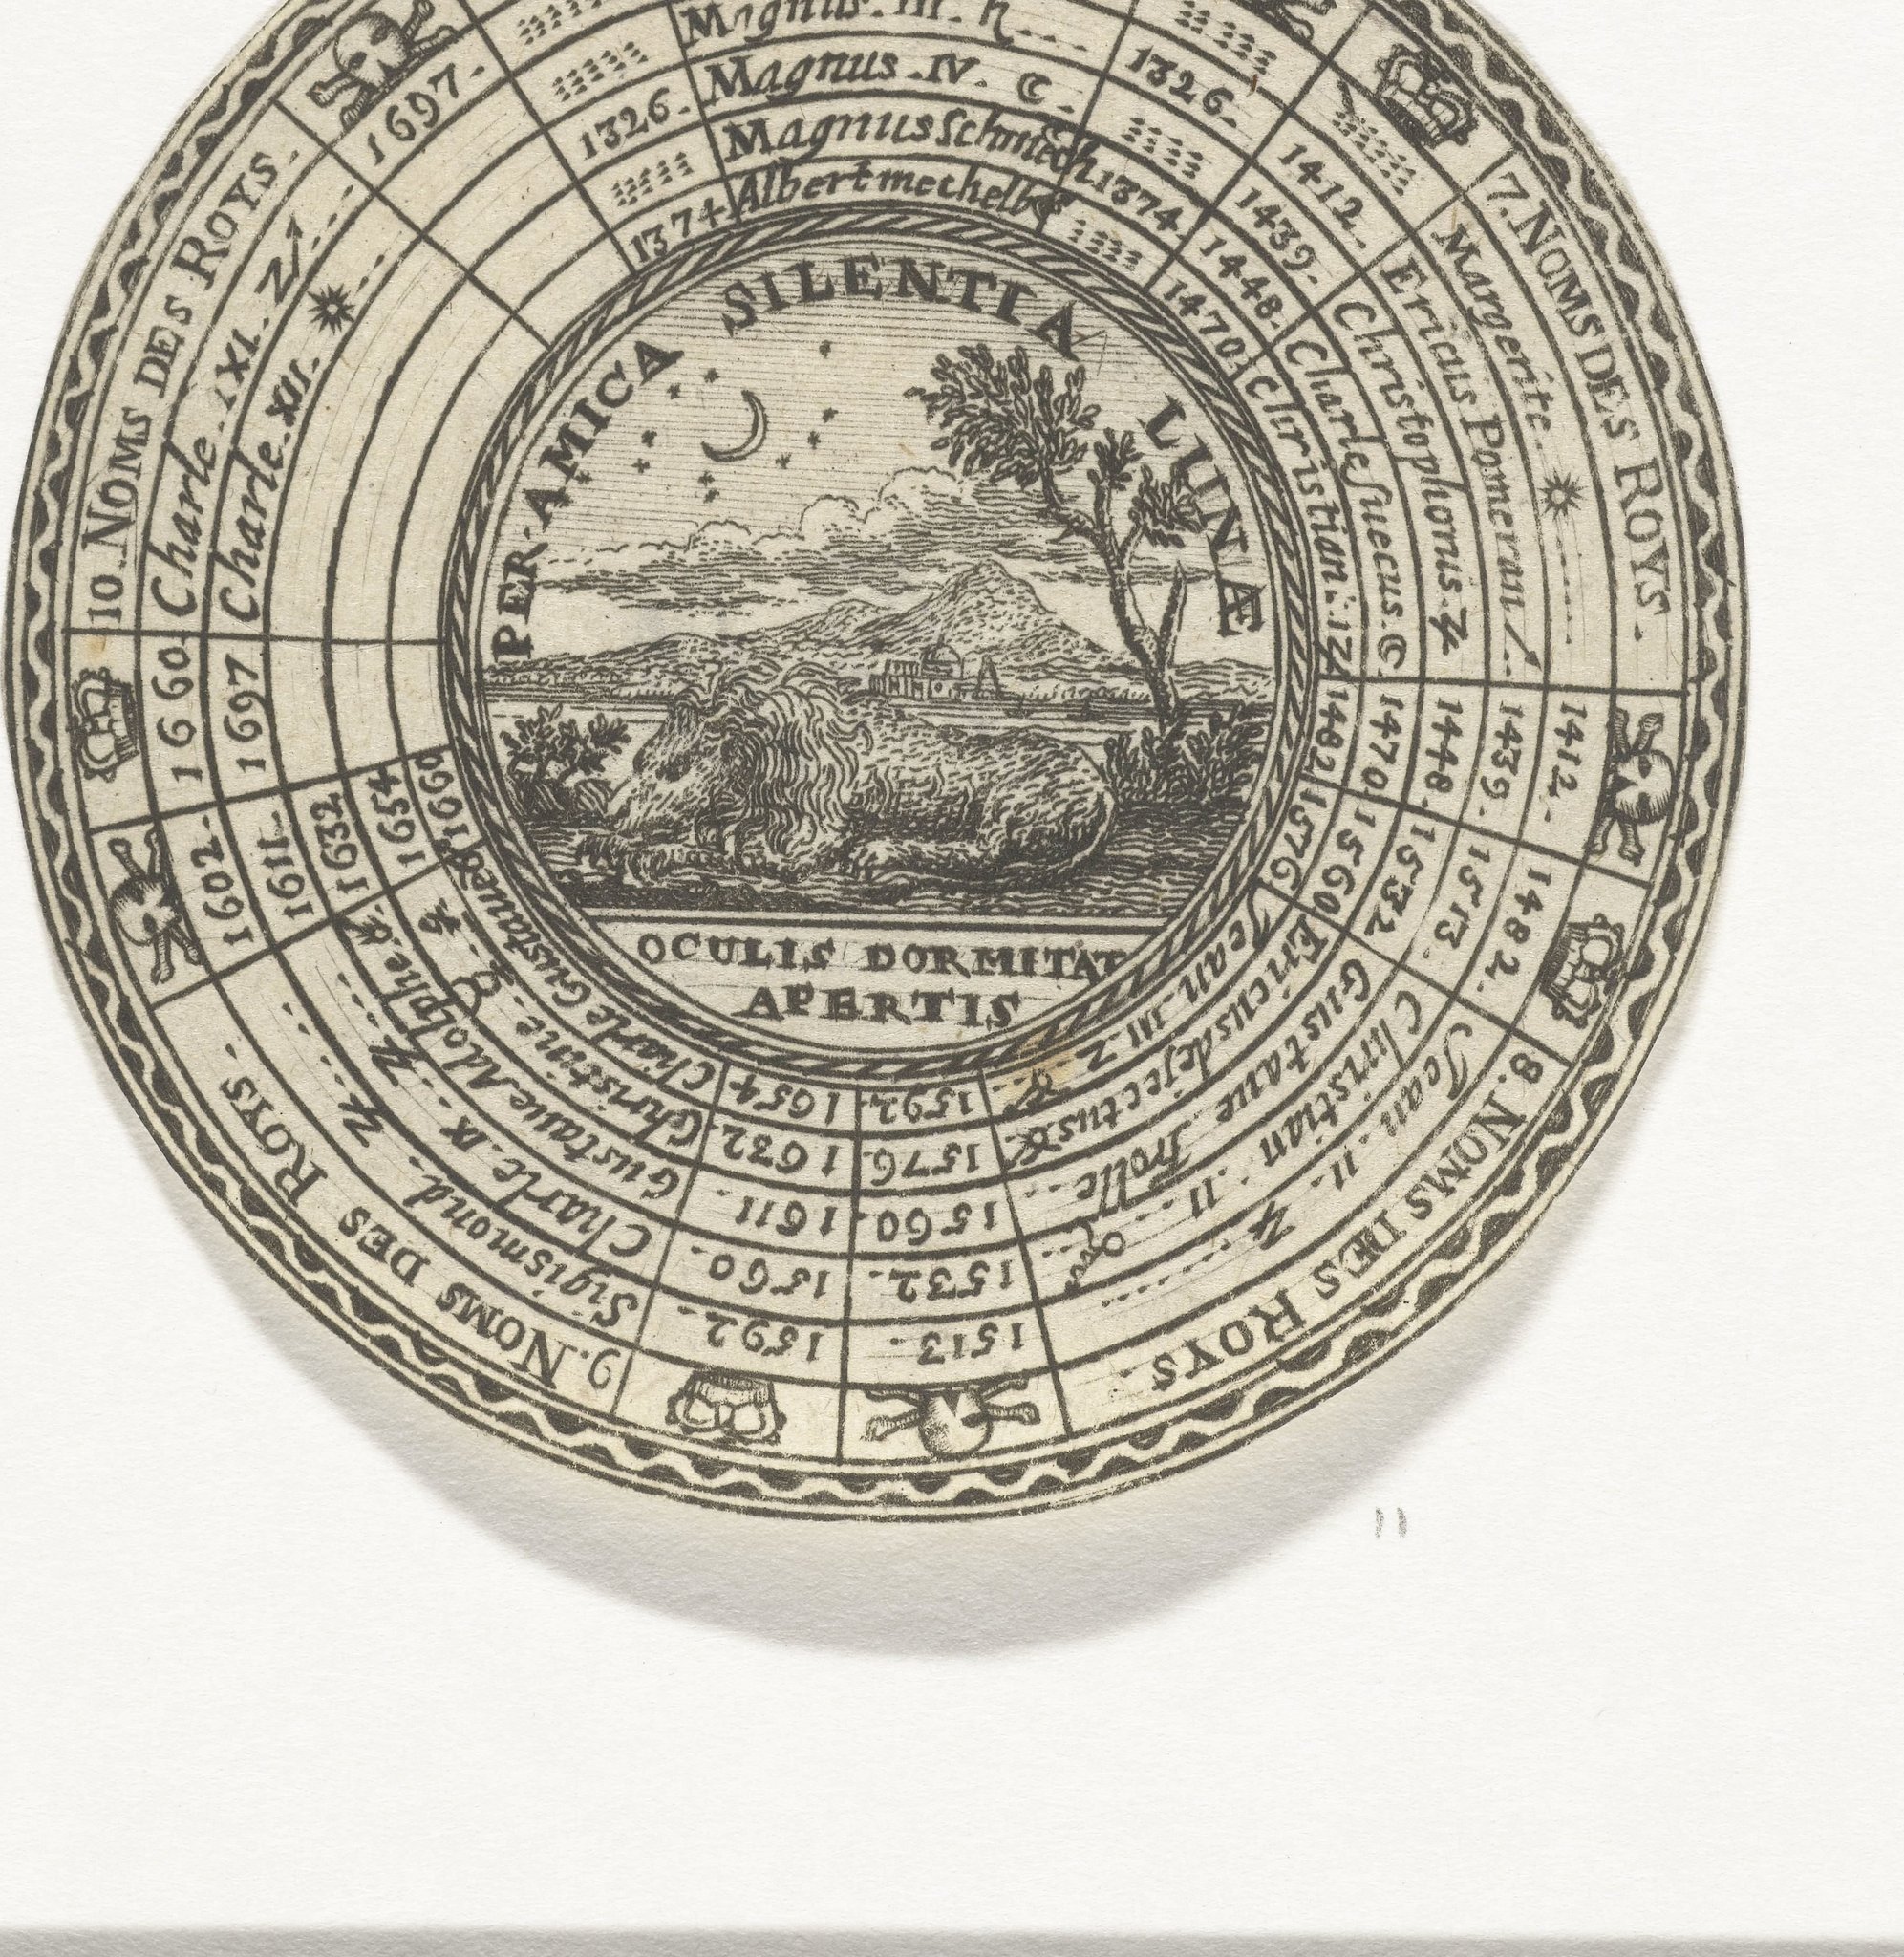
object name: print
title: Penning met een embleem en de namen van Zweedse koningen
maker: Anonymous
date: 1685-1720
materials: paper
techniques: etching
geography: amsterdam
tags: beasts of prey, predatory animals: lion (+ animals used symbolically), device (as symbol of the state, etc.), abstract ideas and concepts (+ emblematical representation of concept), king, seal (symbol of sovereignty), mountains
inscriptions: number: ‘12’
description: Ontwerp van een ronde penning met, in zes concentrische cirkels, de namen van Zweedse koningen en hun regeringsjaren, beginnende bij koning Birger I en eindigend bij koning Karel XII. In het midden van de penning een embleem met een leeuw in een berglandschap en het motto:"Per Amica Silentia Lunae".